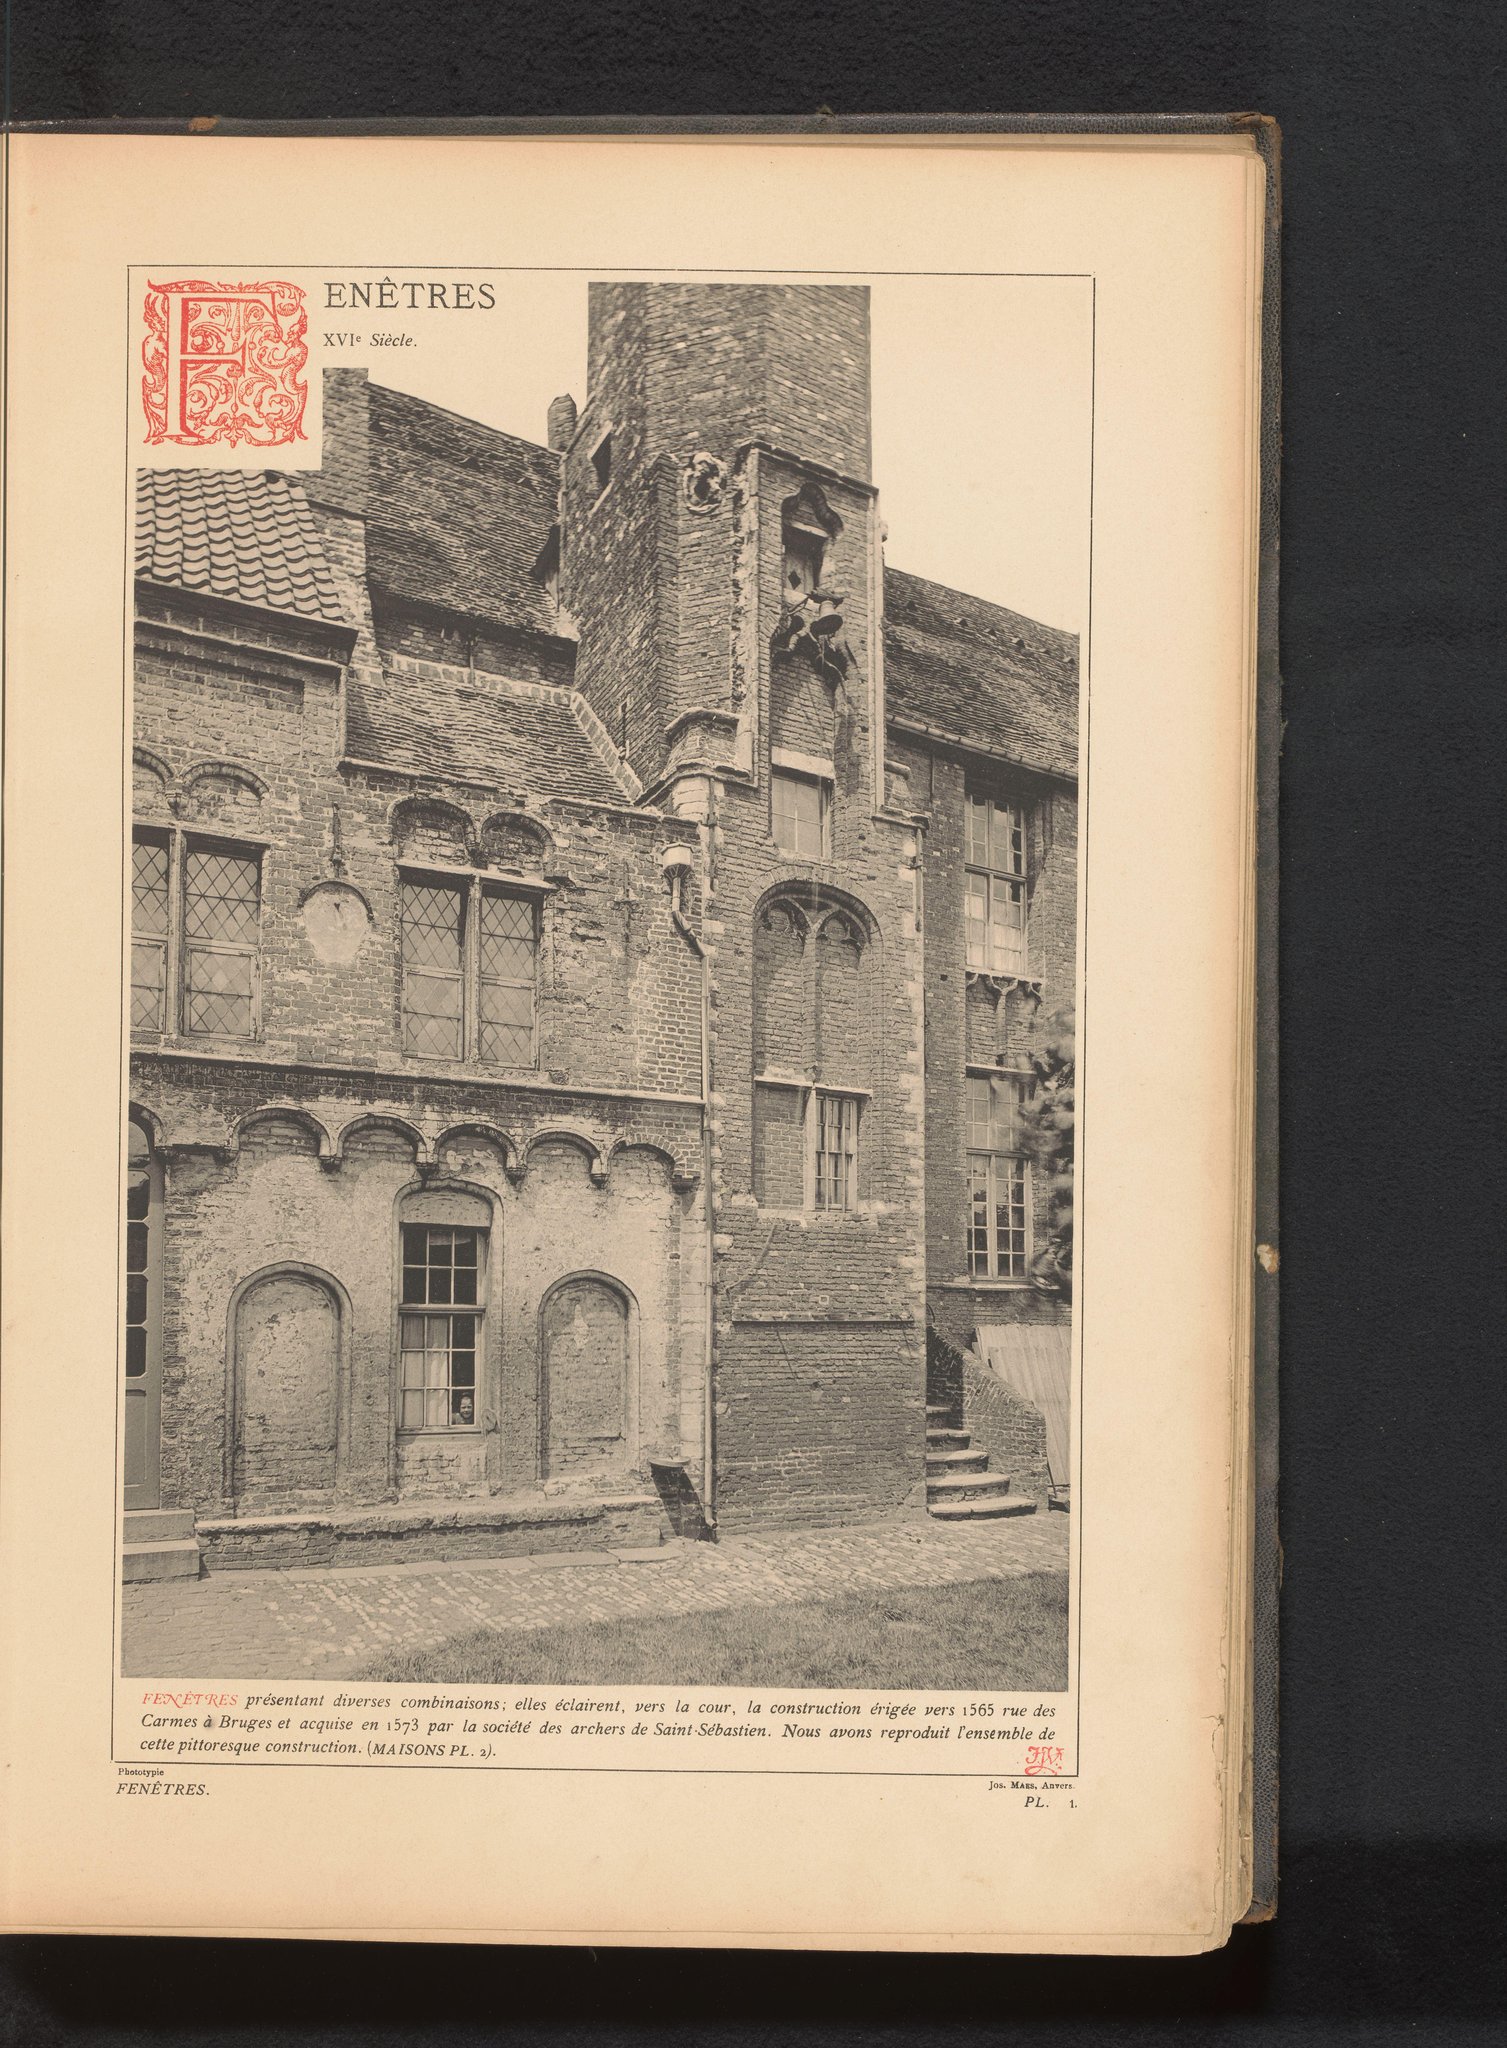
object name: page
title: Fenêtres, XVIe Siècle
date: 1881-1889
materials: paper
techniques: photograph, photolithography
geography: bruges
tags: civic architecture; edifices; dwellings, bruges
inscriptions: inscription: ‘FENÊTRES. PL. 1.’, monogram: ‘JJvY’, inscription: ‘FENÈTRES présentant diverses (...)’